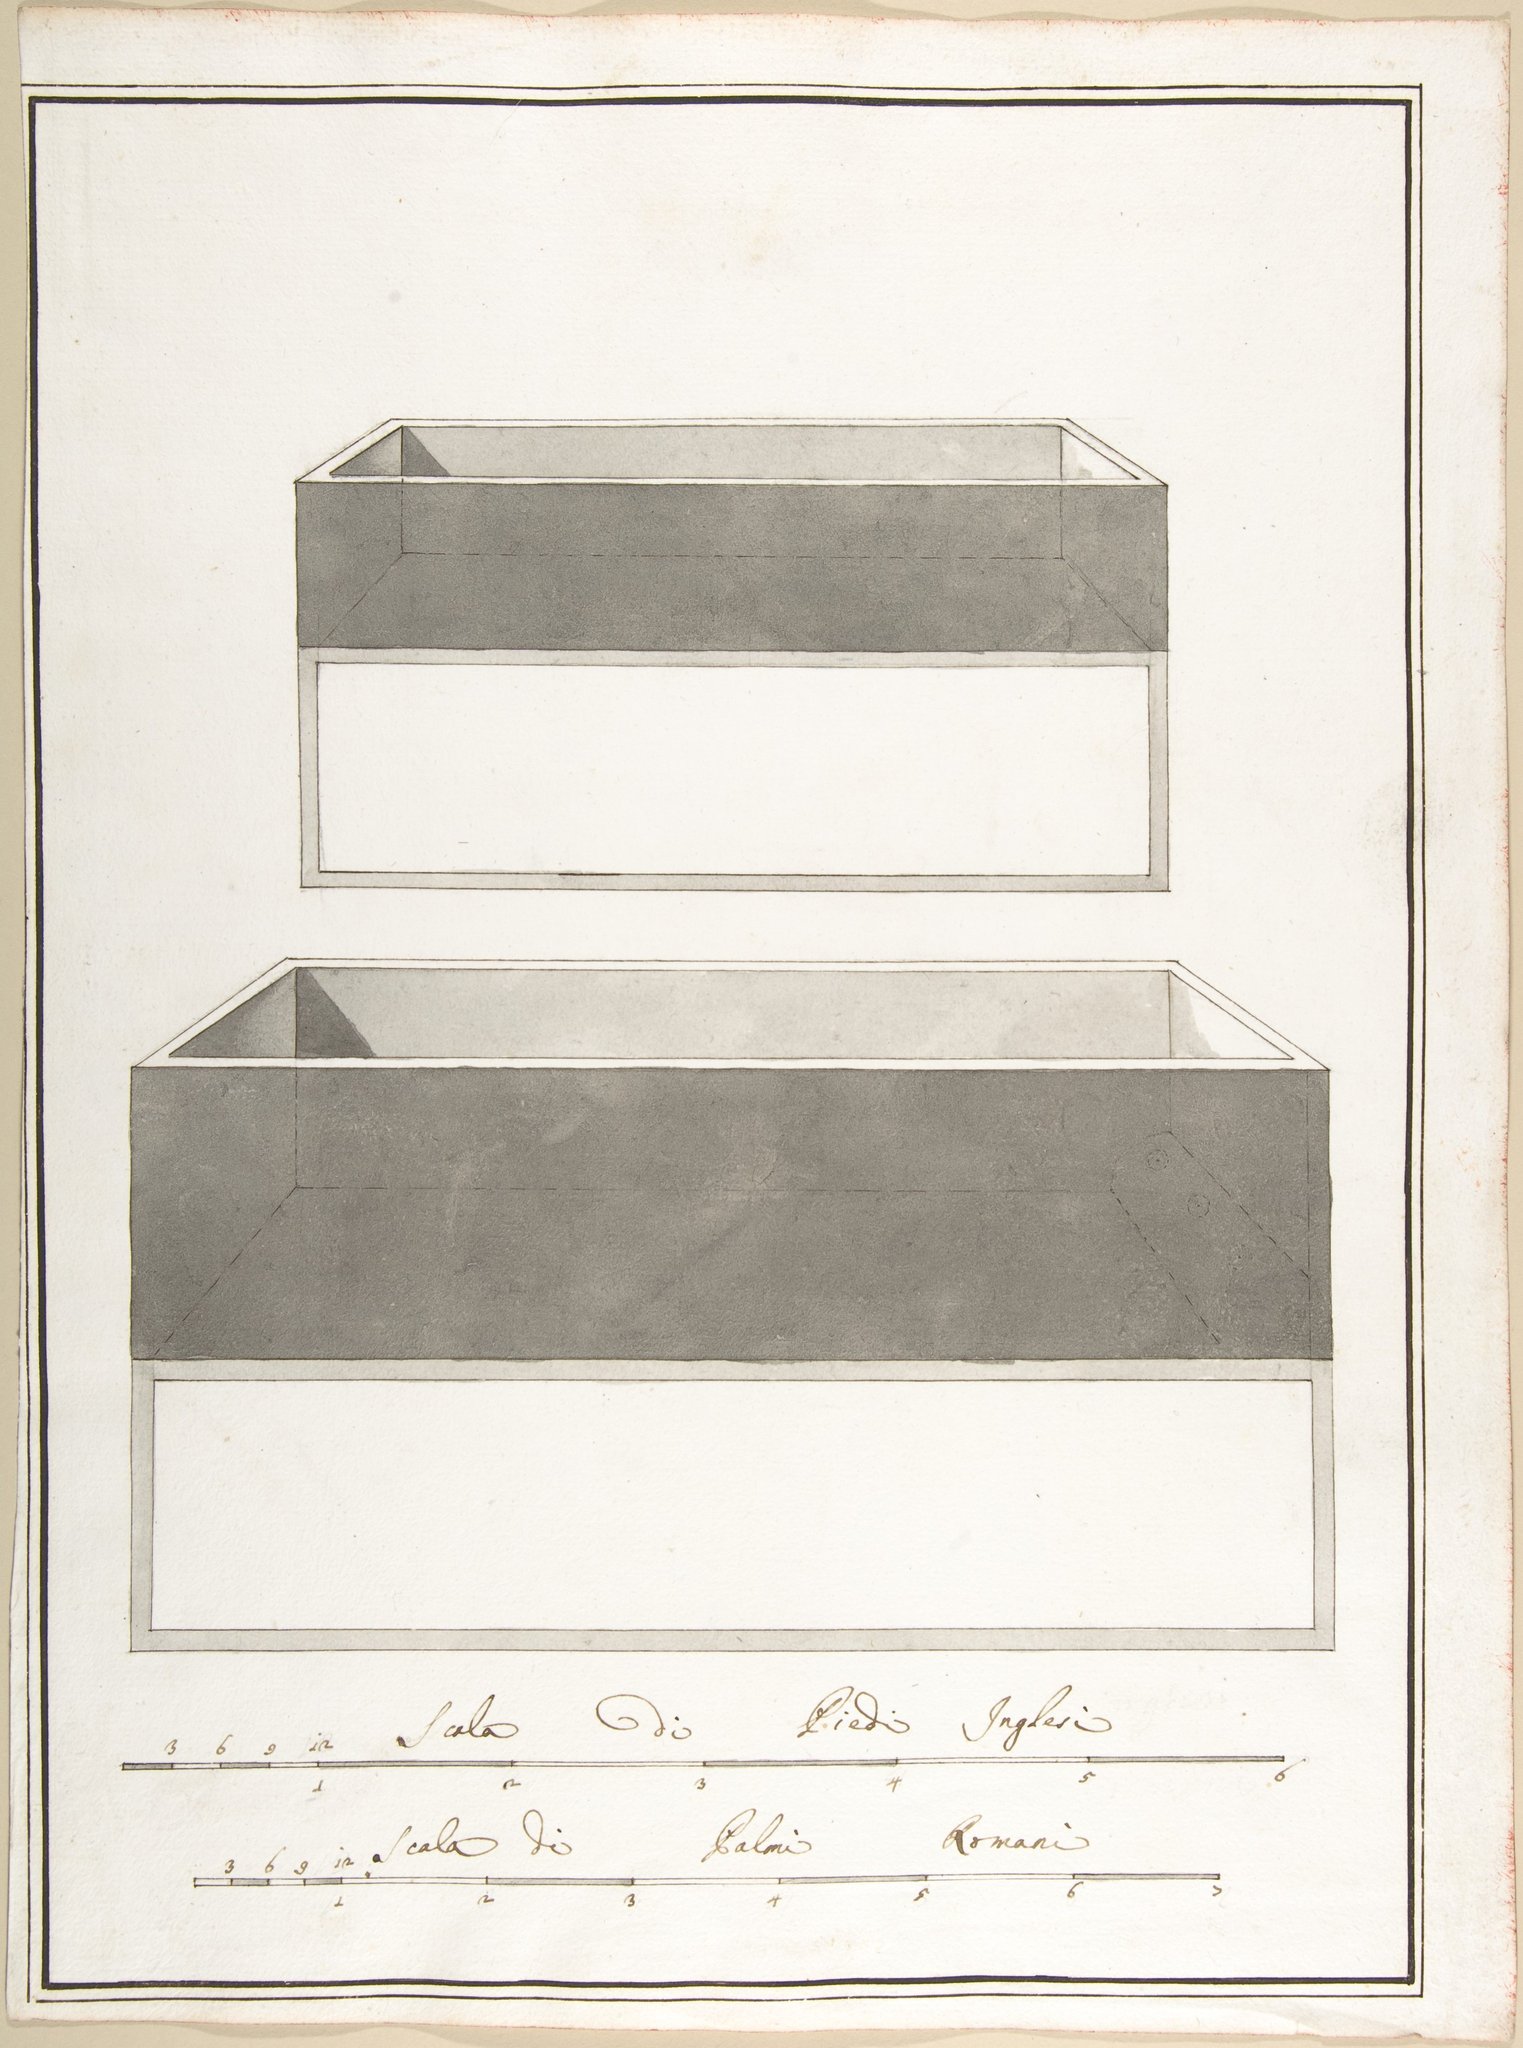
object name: drawing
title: Elevations and Plans of Two Boxes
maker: pietro paolo coccetti (cocchetti)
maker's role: artist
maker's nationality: italian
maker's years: 1710-1727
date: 1710-1727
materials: graphite, ink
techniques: brush, pen, wash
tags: boxes